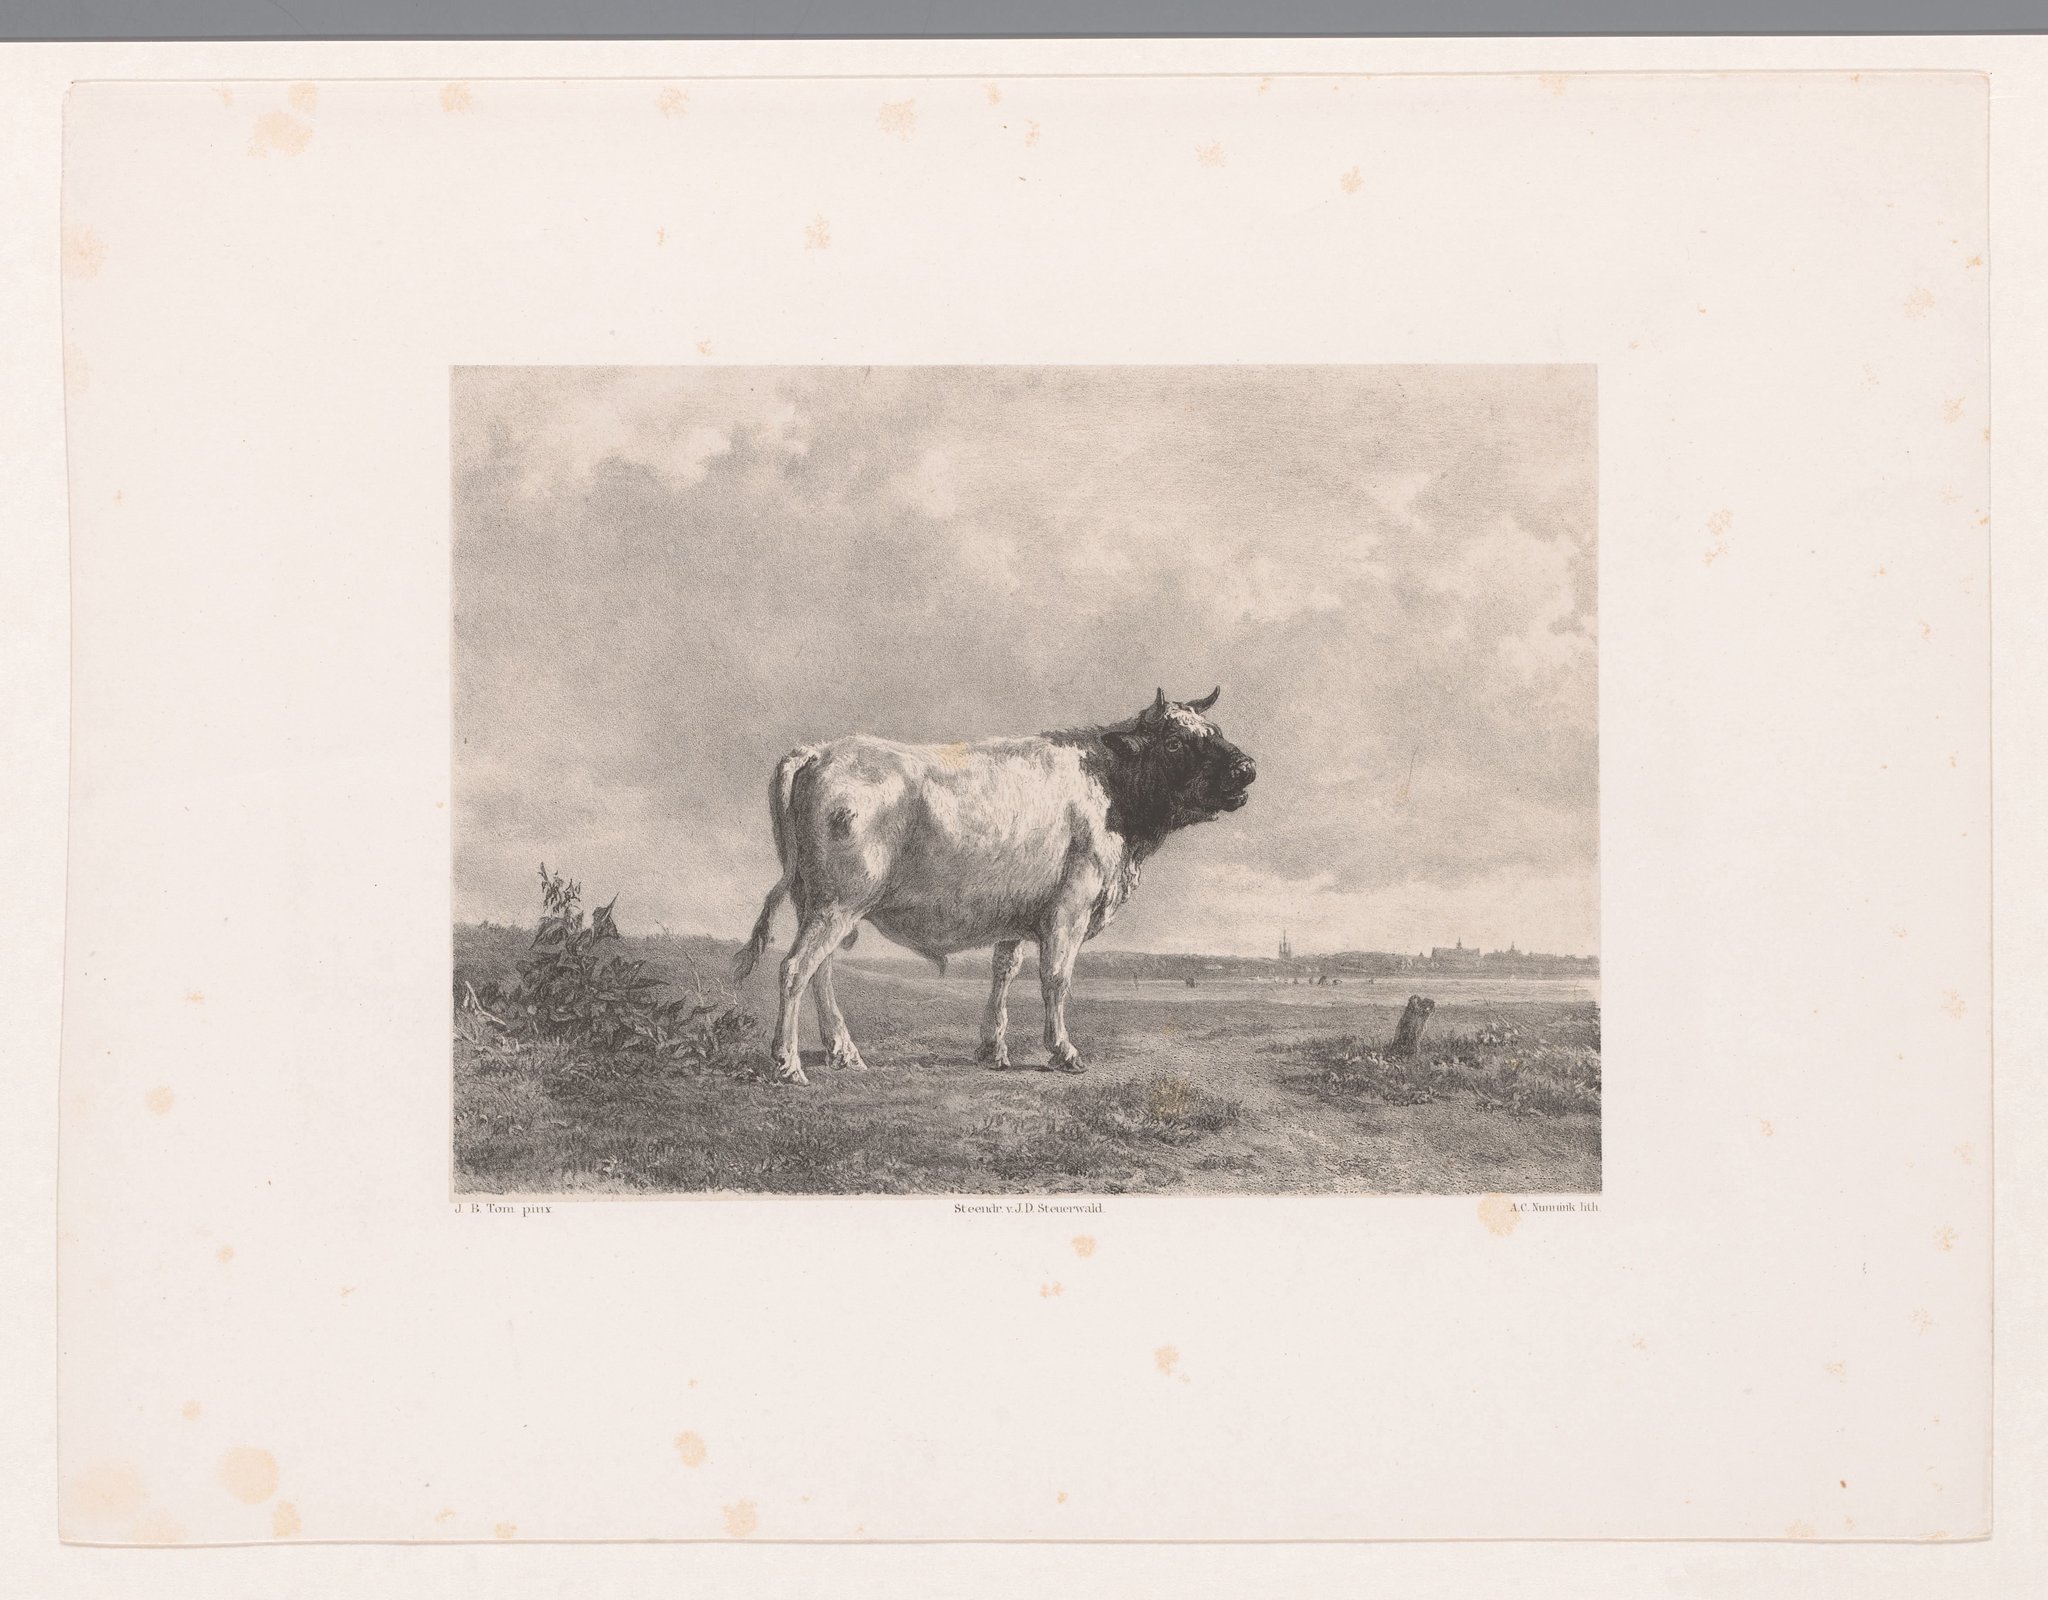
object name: print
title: Jonge loeiende stier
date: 1833-1863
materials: paper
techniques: lithograph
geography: the hague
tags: bull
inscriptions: collector's mark: Lugt 2228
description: In een polderlandschap staat een loeiende stier.